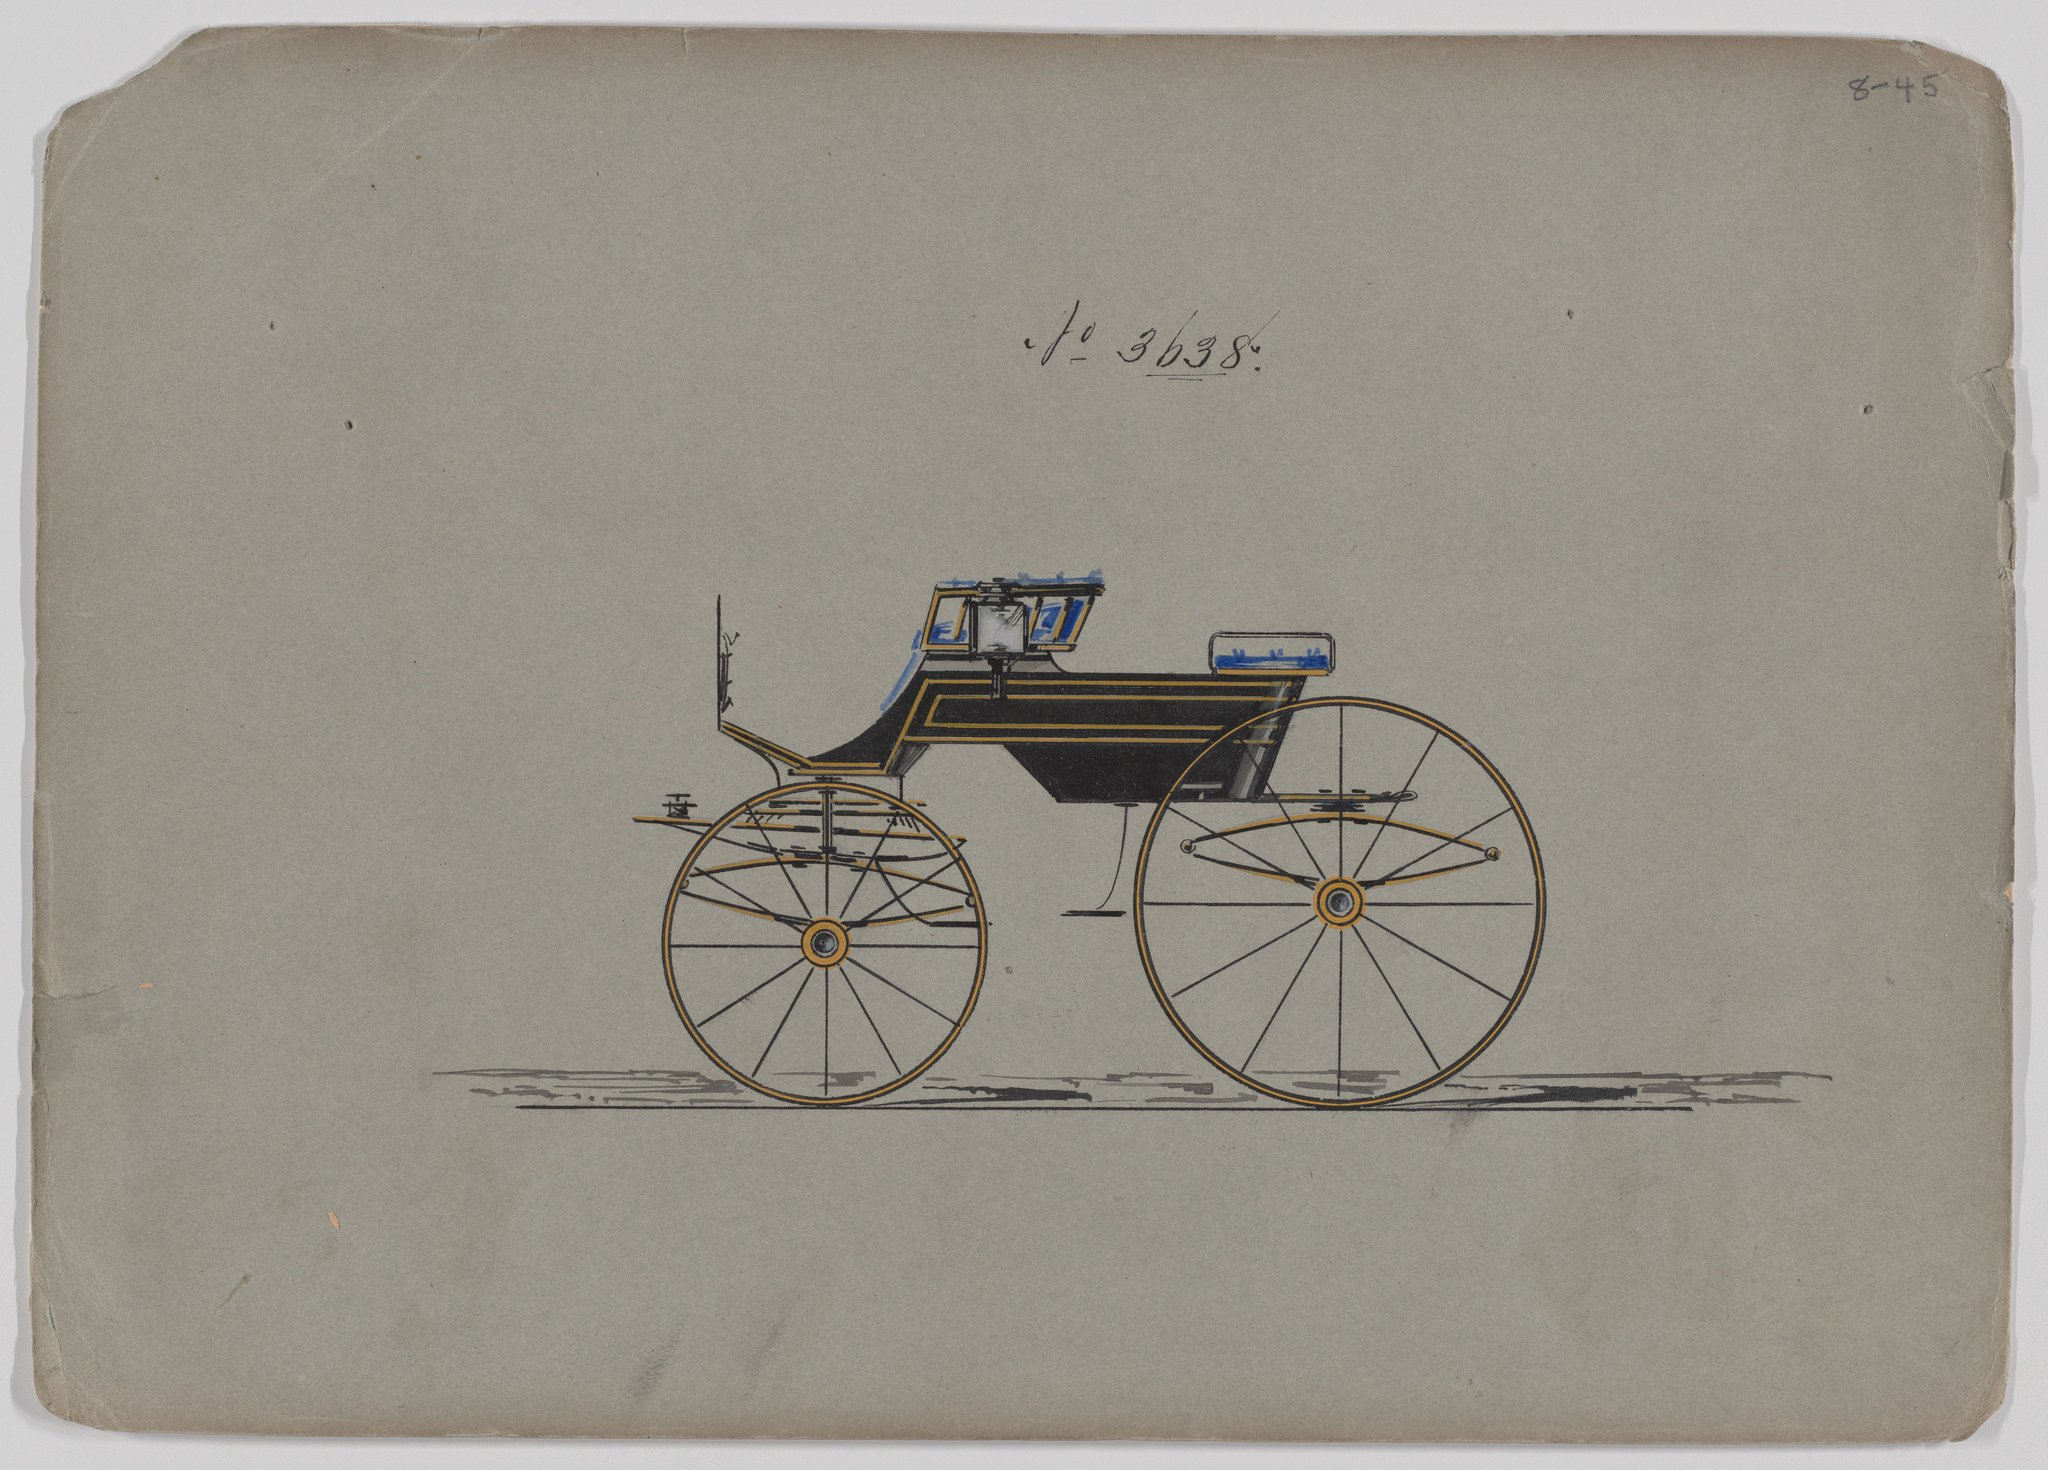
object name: drawing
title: Design for 4 seat Phaeton, no top, no. 3638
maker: brewster & co.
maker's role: manufacturer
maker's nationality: american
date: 1880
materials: gouache, ink, watercolor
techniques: pen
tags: carriages